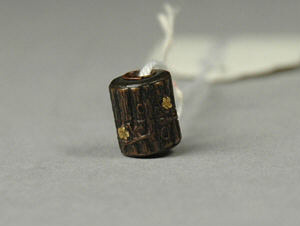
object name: ojime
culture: japanese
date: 1801-1900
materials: gold, metal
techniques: inlay